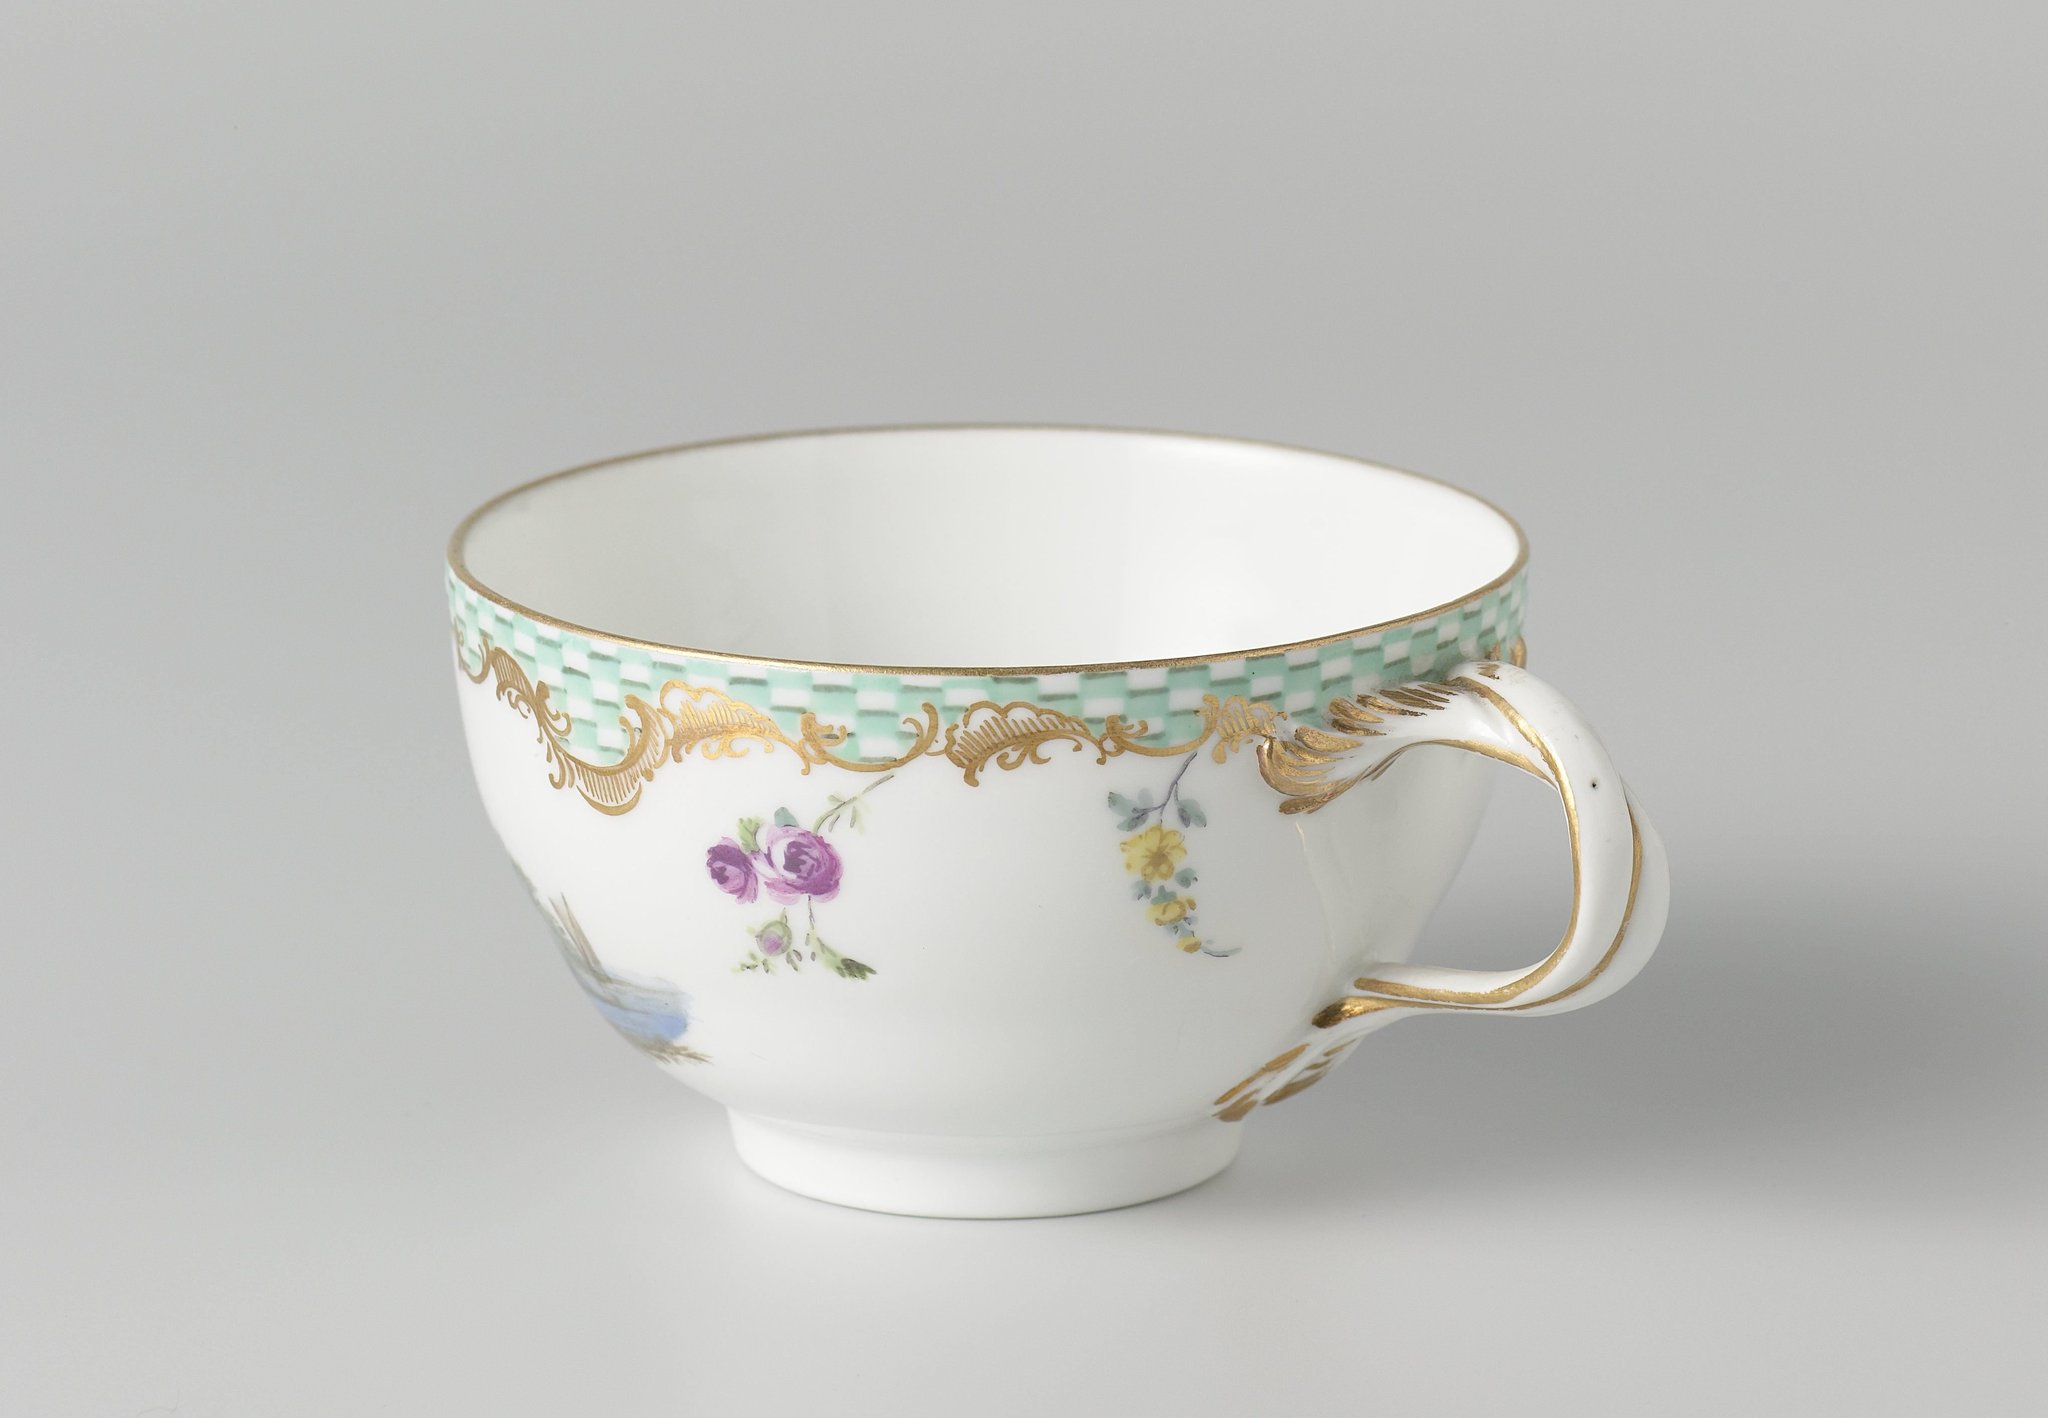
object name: eating drinking utensil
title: Kop, veelkleurig beschilderd met een landschap met figuren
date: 1777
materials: porcelain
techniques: painted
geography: meissen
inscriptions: mold mark: ‘18’, factory mark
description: Lage kop met oor, van beschilderd porselein. De kop is beschilderd met landschappen waarin figuren en langs de rand een brede strook groen vlechtwerk. De kop is gemerkt.